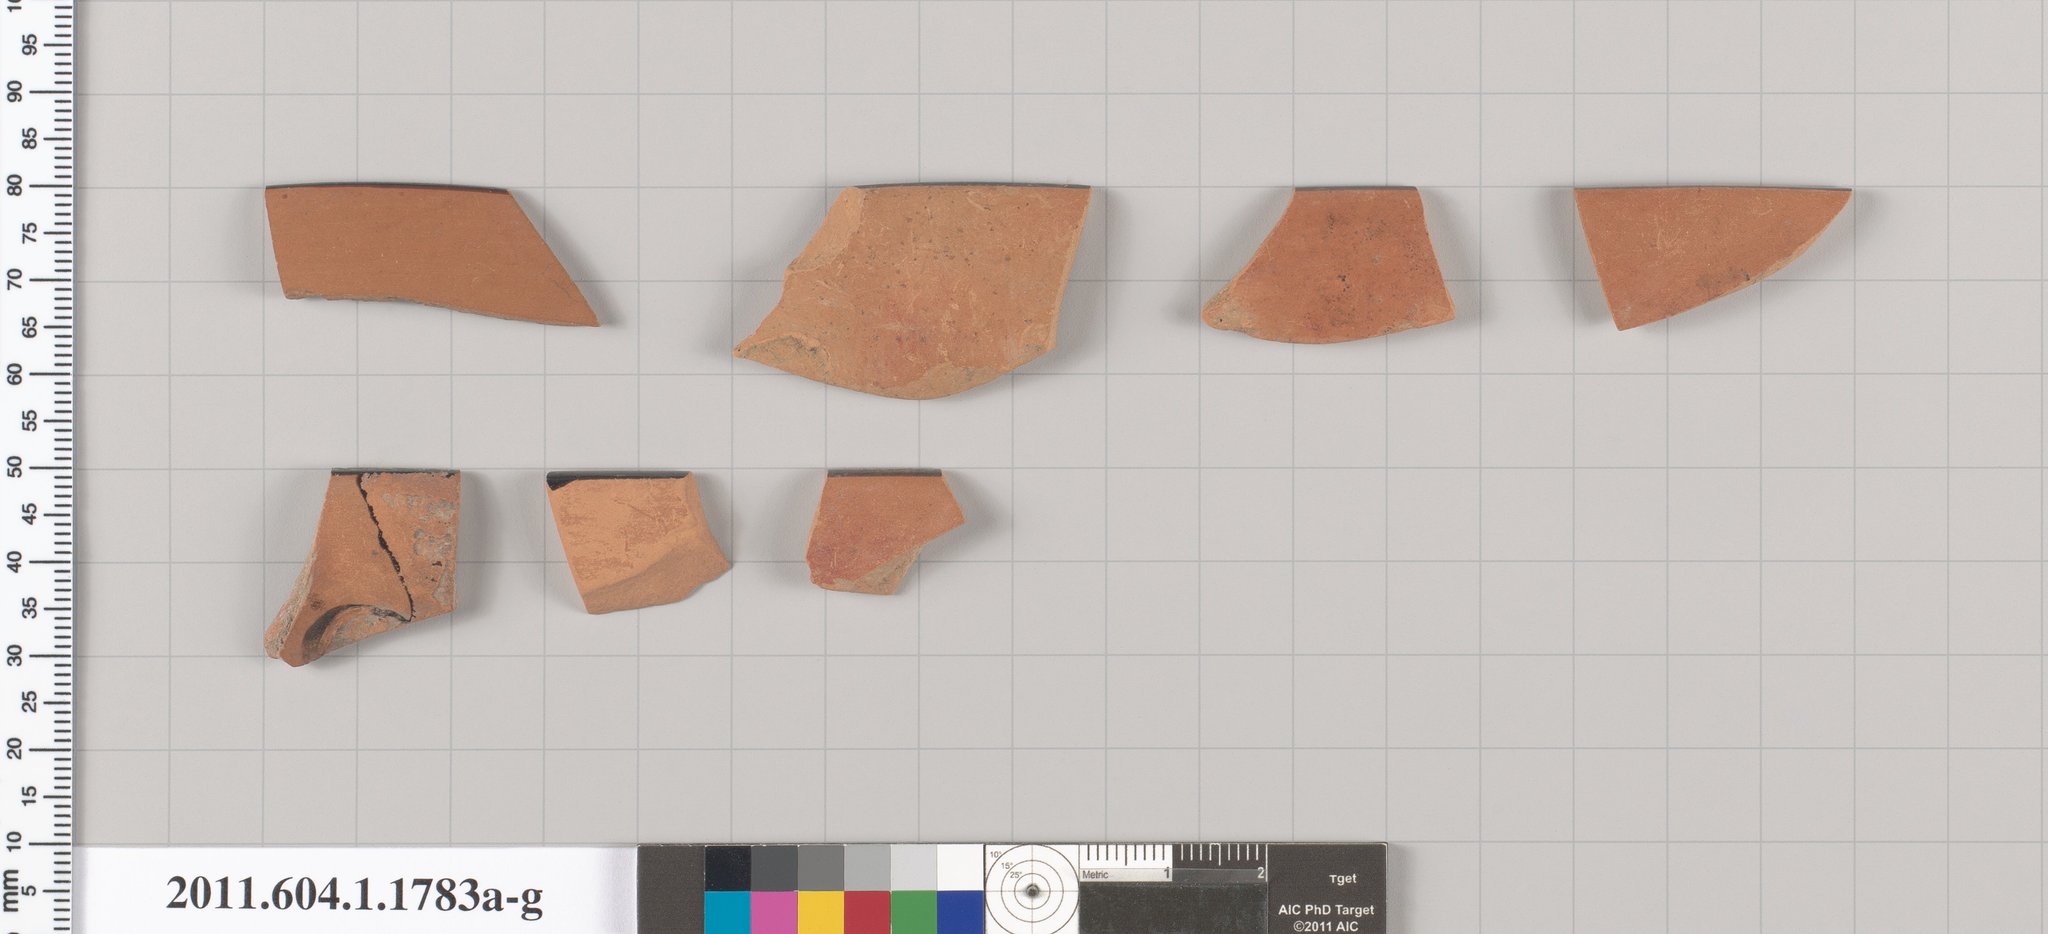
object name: kylix fragment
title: Terracotta rim fragments of kylikes(drinking cups)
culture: greek, attic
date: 500-401 BCE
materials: terracotta